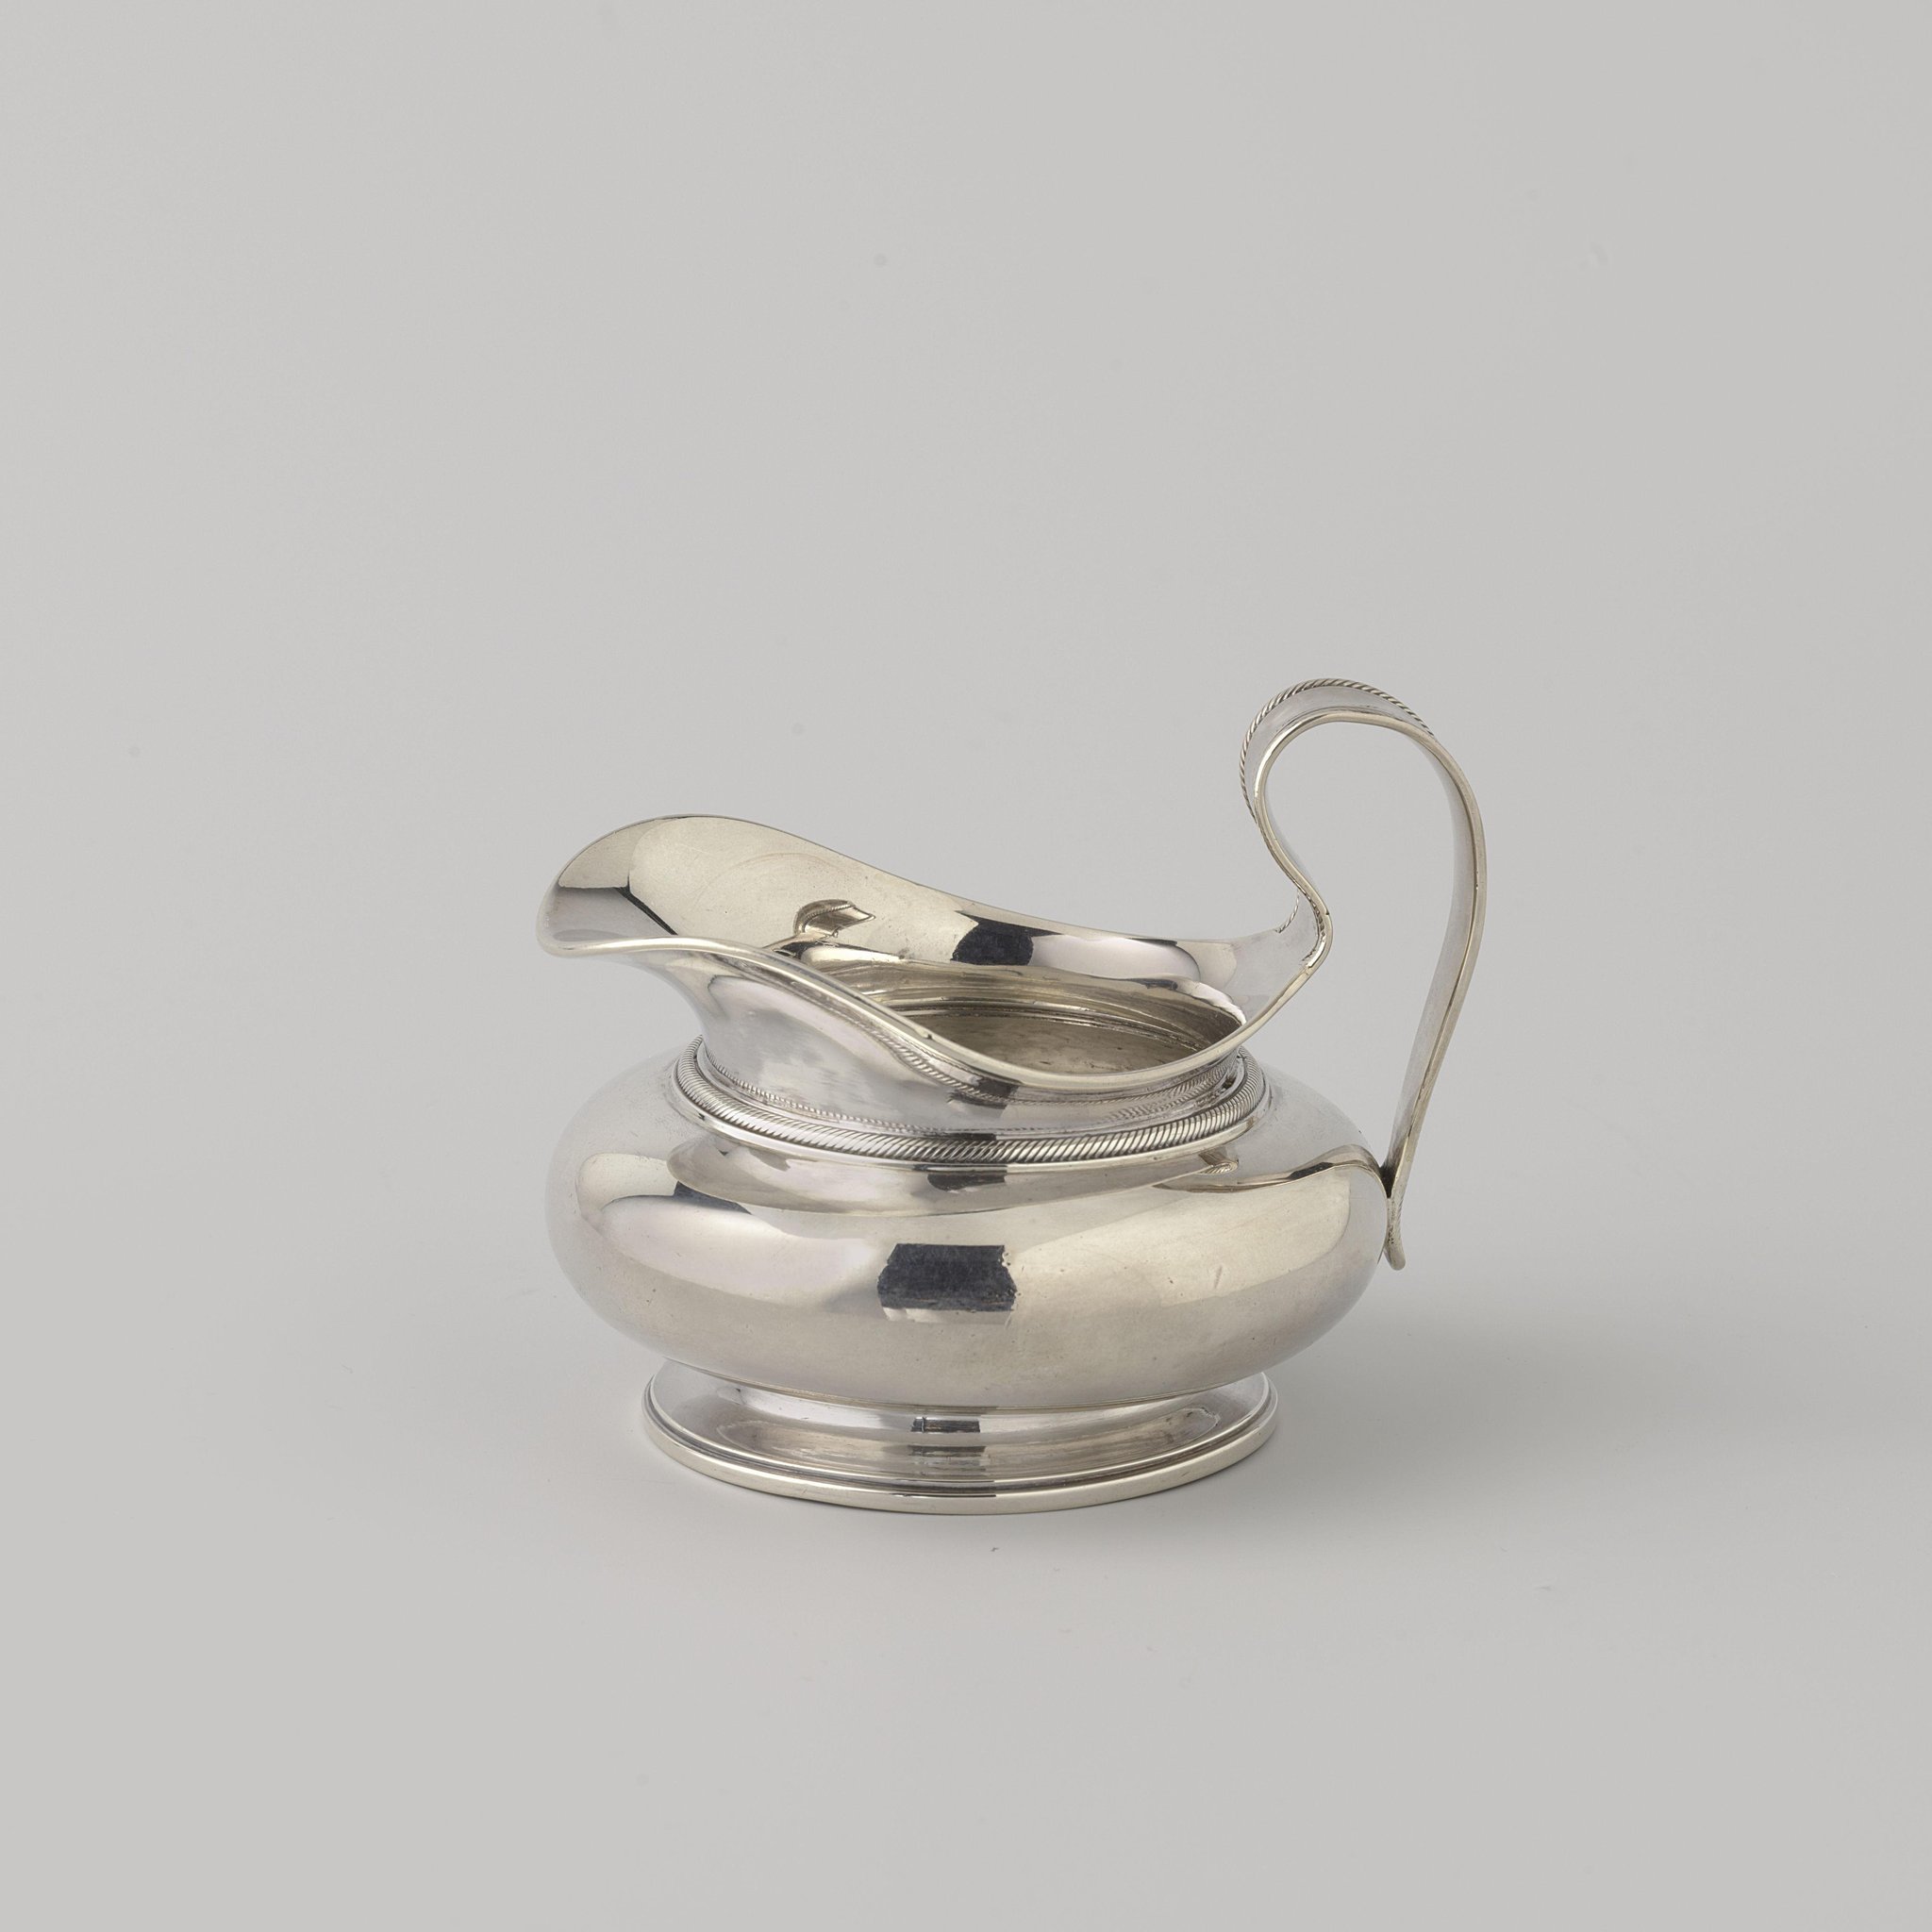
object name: milk jug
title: Melkkan met het familiewapen Clifford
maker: theodorus gerardus bentvelt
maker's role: silversmith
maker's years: 1782-1853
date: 1837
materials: silver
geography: amsterdam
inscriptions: alloy mark, maker's mark, date letter: ‘C’, assay office mark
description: Op een gewelfde, zich verjongende voet rust de ronde kan met bol gewelfd, sterk gedrukt lichaam met brede lip. De kan heeft een hoog opstaand, plat oor, dat is afgezet met een kabelrand, die eveneens rond de aanzet van de lip loopt. Op het lichaam is het wapen Clifford met het helmteken en schildhouders gegraveerd.